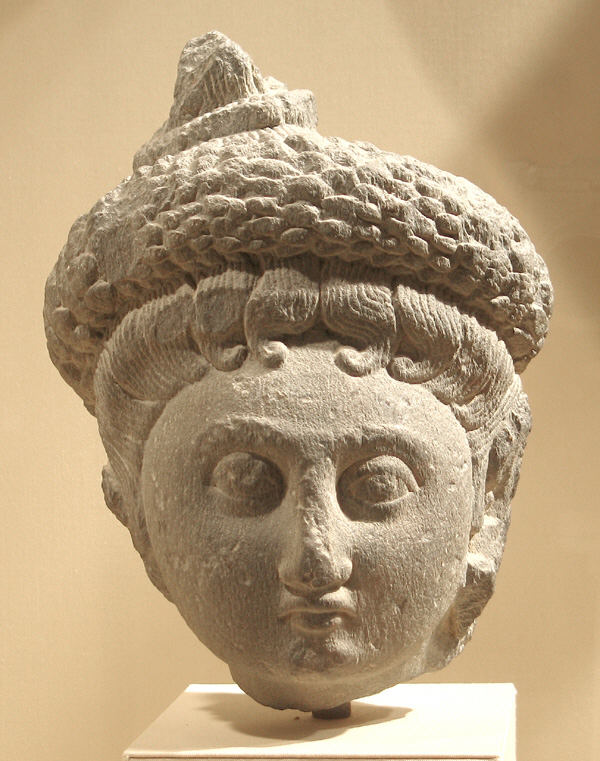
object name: head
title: Head of a Female Deity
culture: gandhara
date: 201-400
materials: stone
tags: gandhara,heads